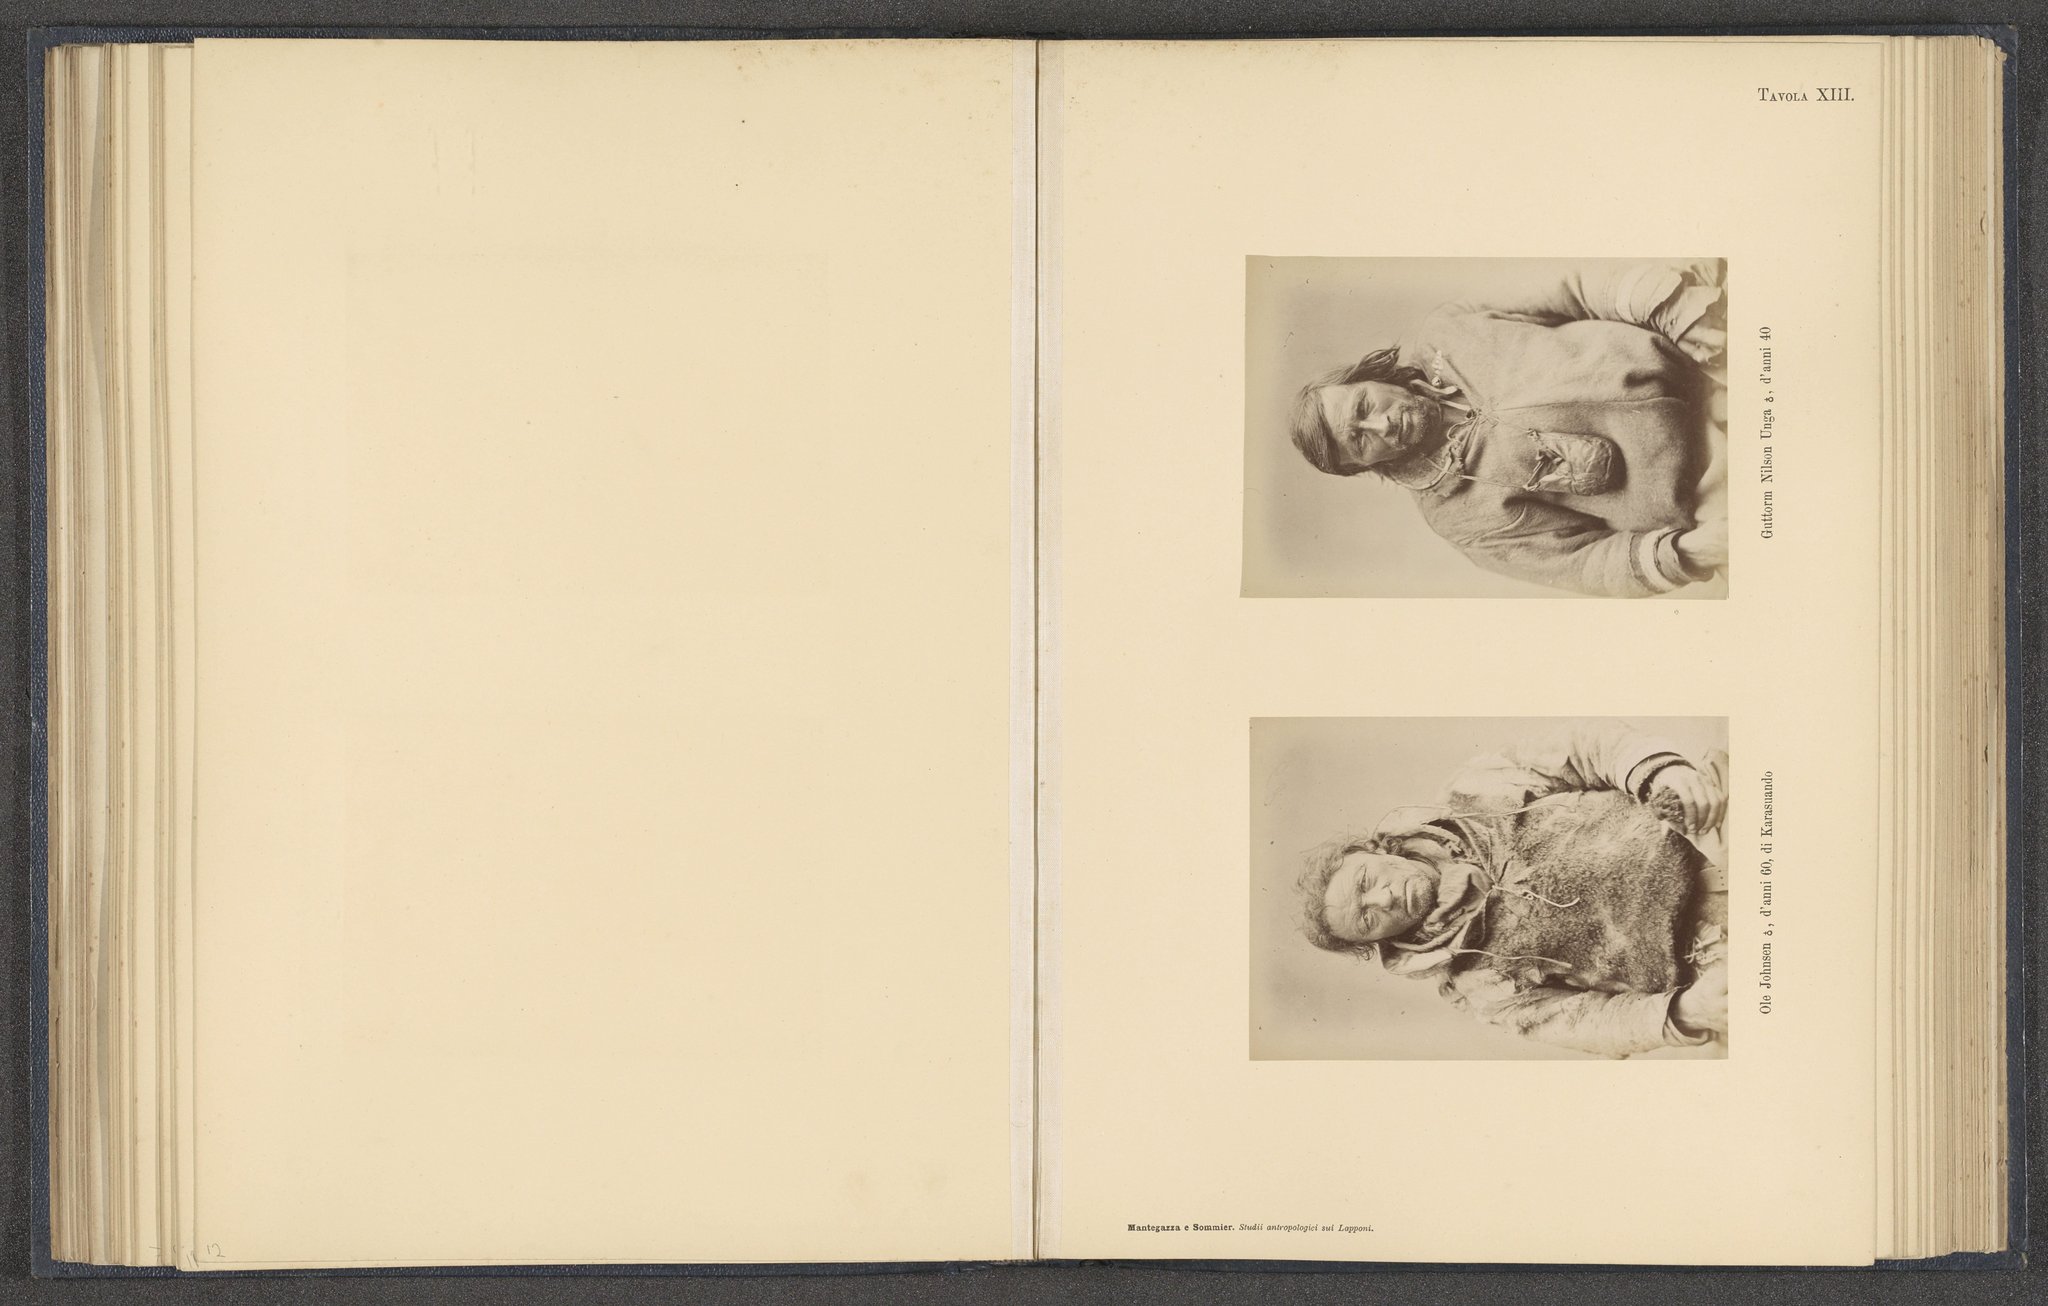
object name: page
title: Guttorm Nilson Unga ♂, d' anni 40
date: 1870-1880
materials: paper, photographic support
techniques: albumen print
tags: adult man (+ front view), fashion, clothing (+ fur used for clothes)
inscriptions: number: ‘Tavola XIII.’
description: Links een vooraanzicht van Ole Johnsen, rechts een vooraanzicht van Guttorm Nilson Unga.